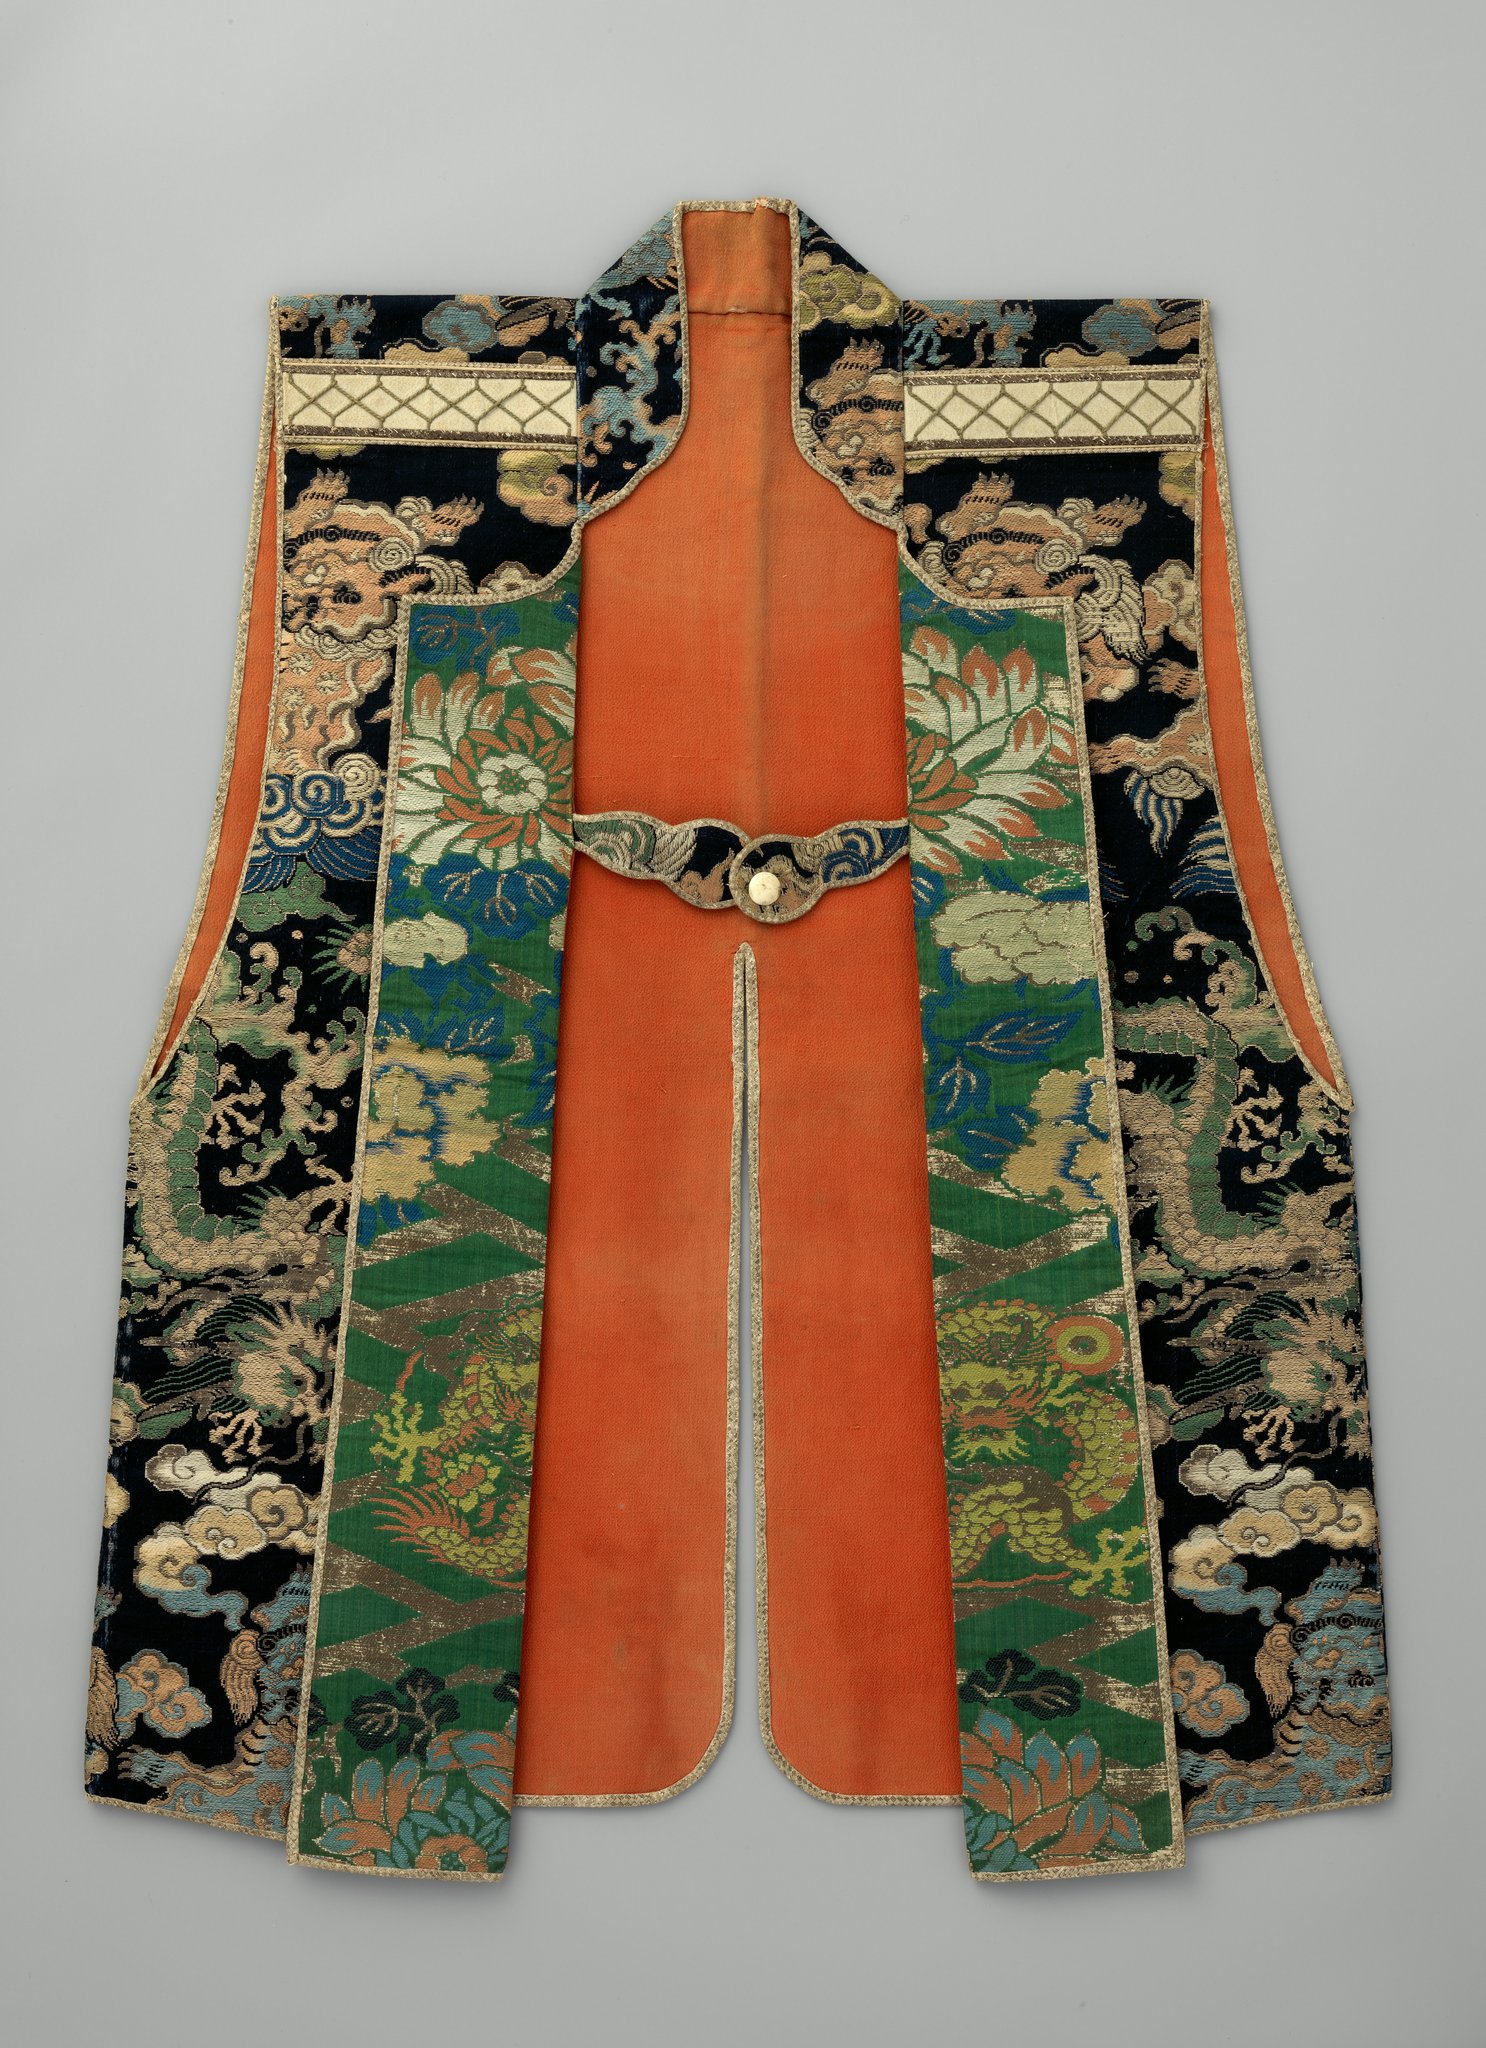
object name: surcoat i jinbaori i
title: Surcoat (Jinbaori) for a Boy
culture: japanese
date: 1701-1833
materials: copper, ivory, metal thread, silver, textile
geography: japan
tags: dragons